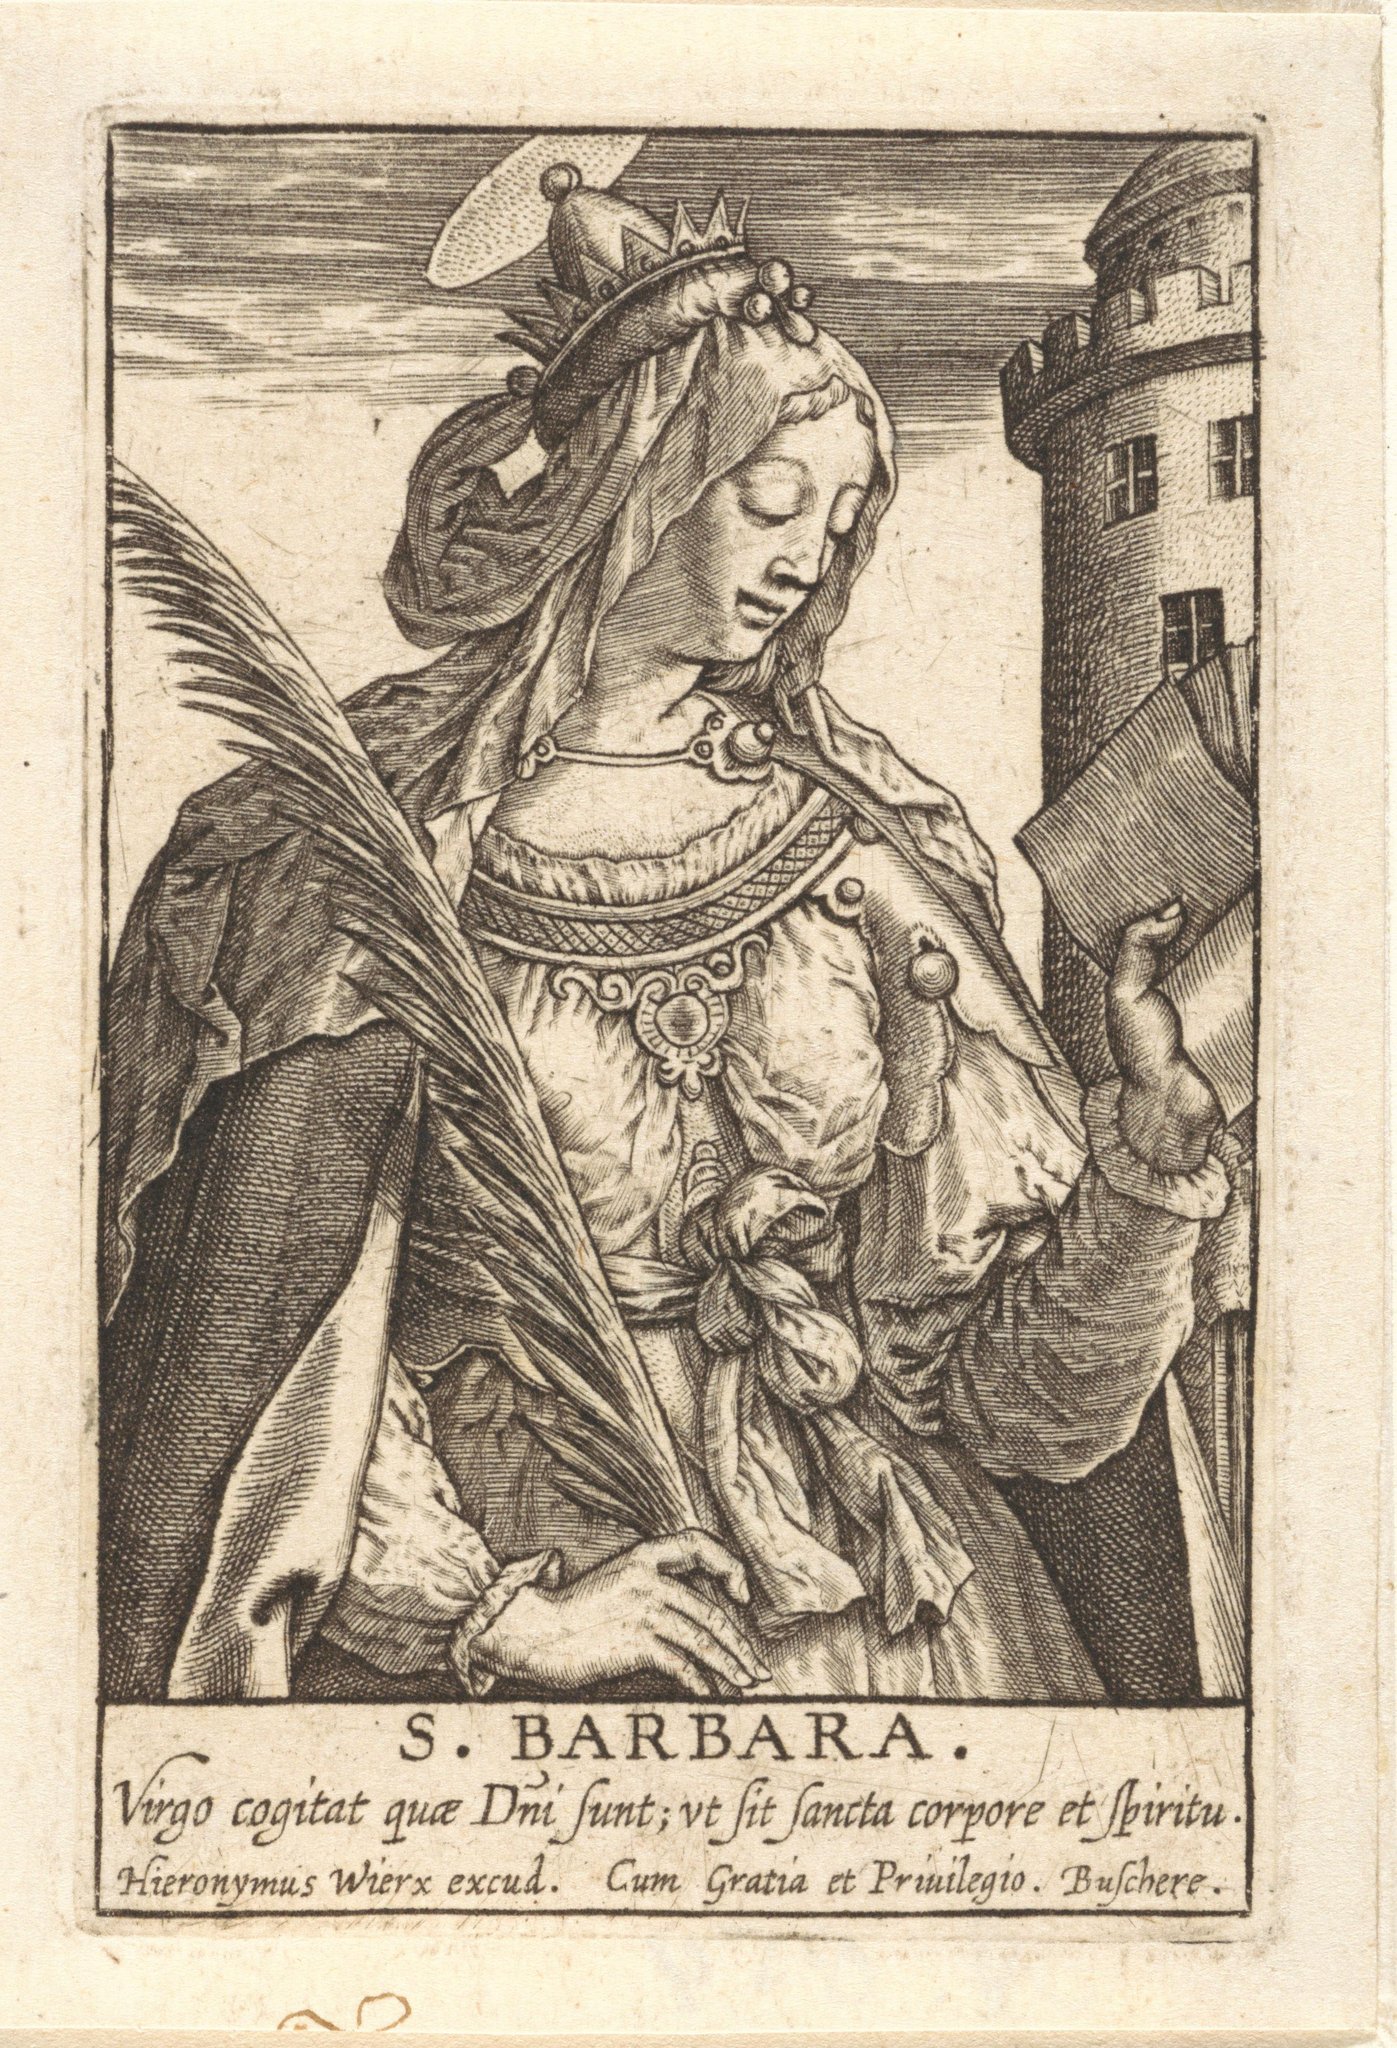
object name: print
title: H. Barbara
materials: paper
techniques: engraving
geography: antwerp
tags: the virgin martyr barbara; possible attributes: book, cannon(ball), crown, cross, chalice with wafer, dioscuros (her father), peacock feather, sword, torches, mason's tools, tower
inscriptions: collector's mark: Lugt 2228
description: De heilige Barbara, in haar ene hand houdt ze een palmtak als symbool voor haar martelaarschap, in haar andere een opengeslagen Bijbel. Op de achtergrond de toren waarin zij door haar vader was opgesloten. In de marge een onderschrift in het Latijn.